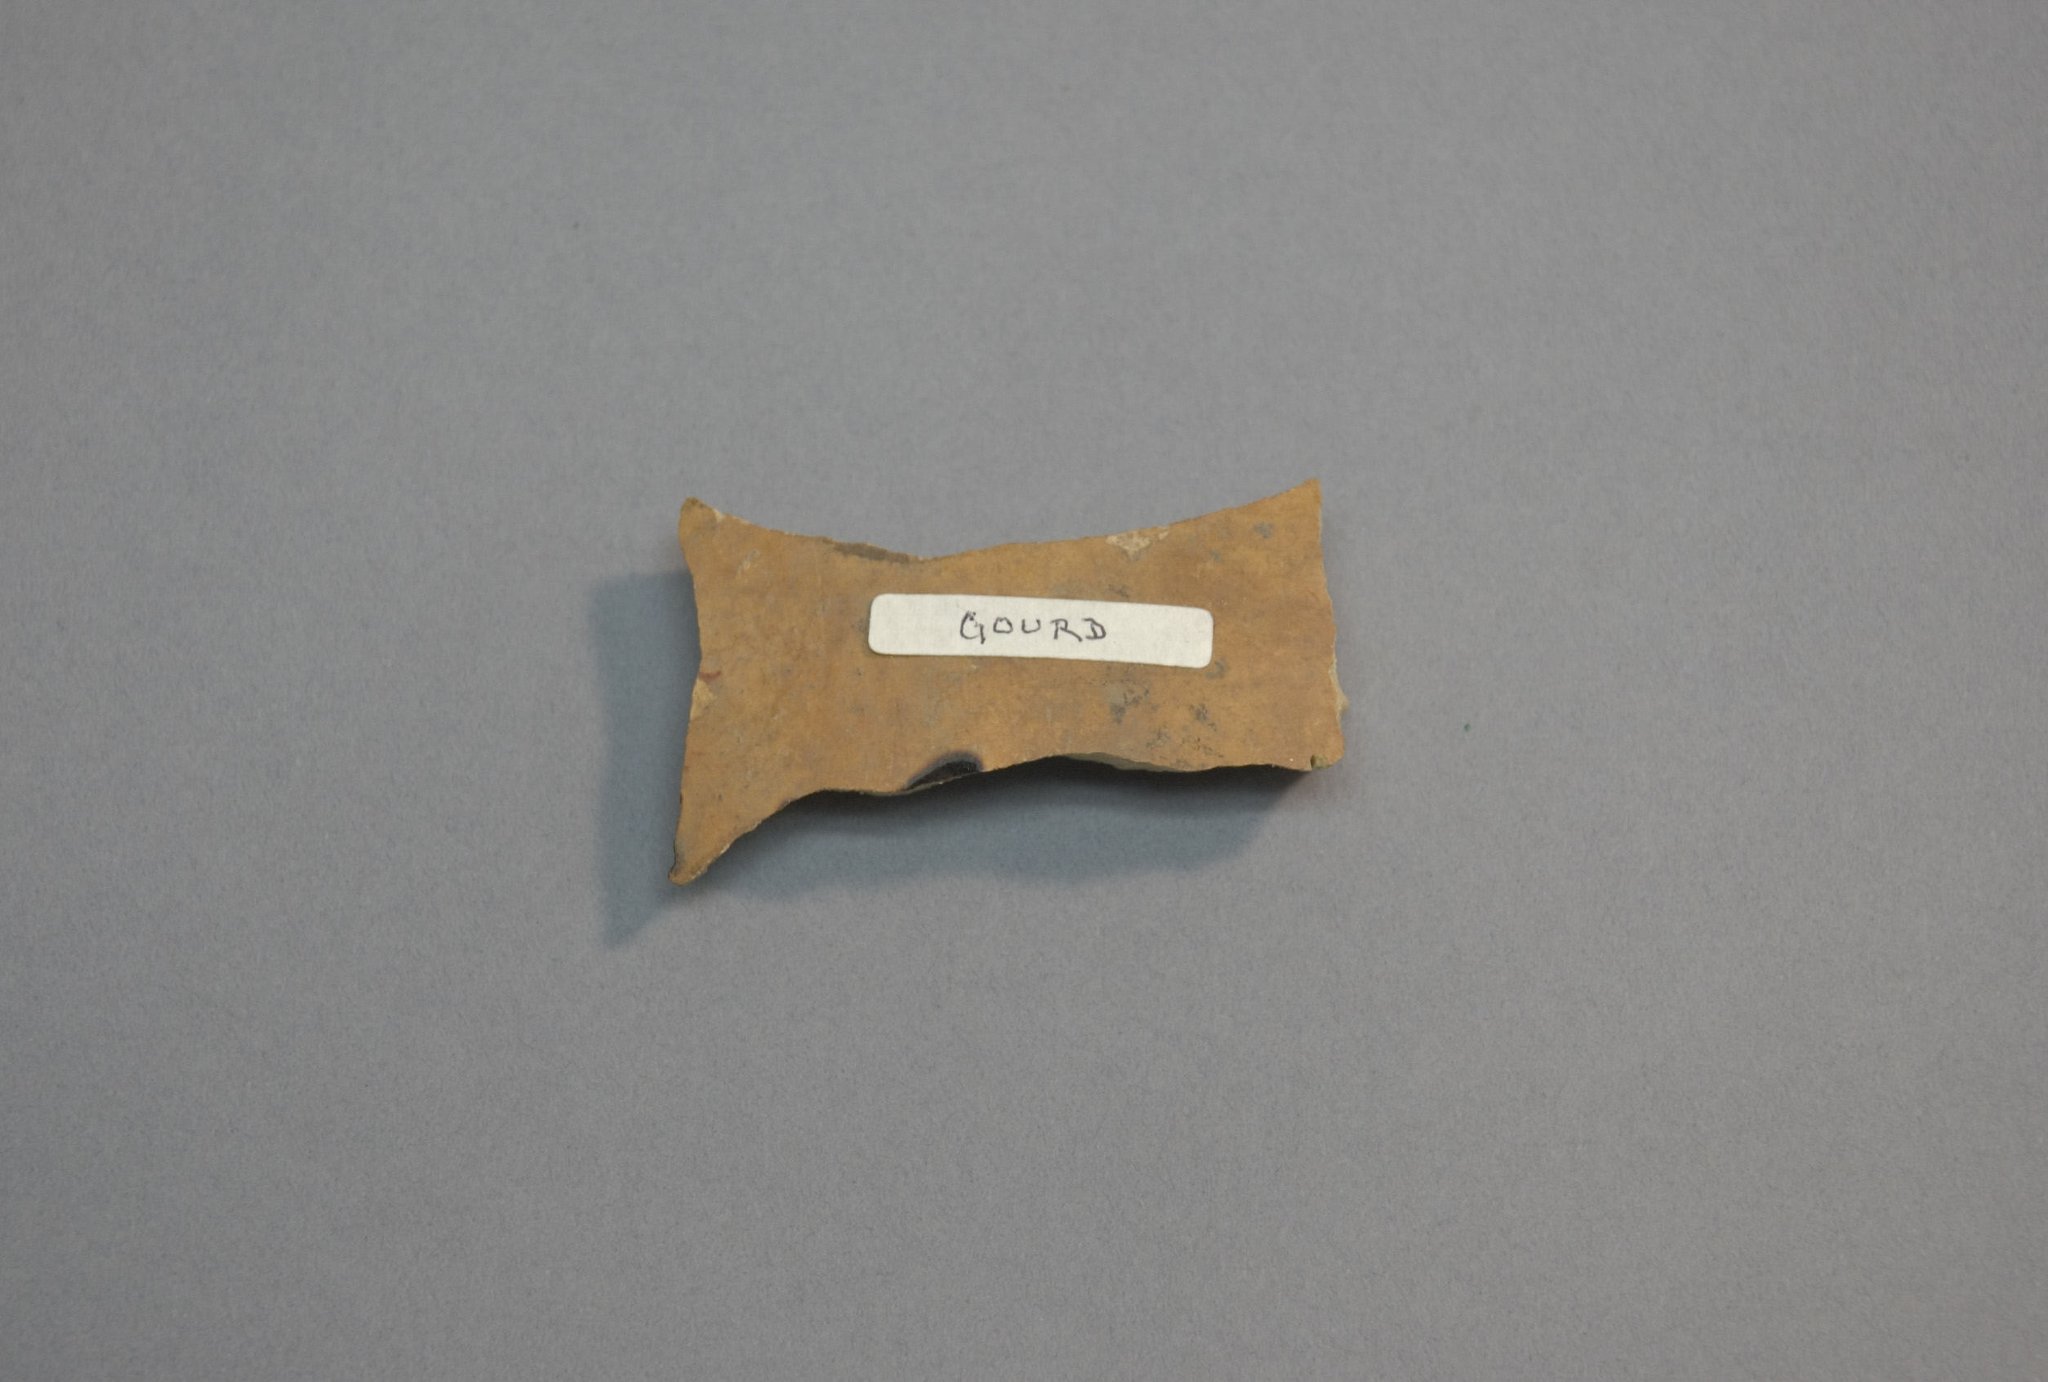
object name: jade carving material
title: Piece of Gourd Material for Polishing Wheel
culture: chinese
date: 1901-2000